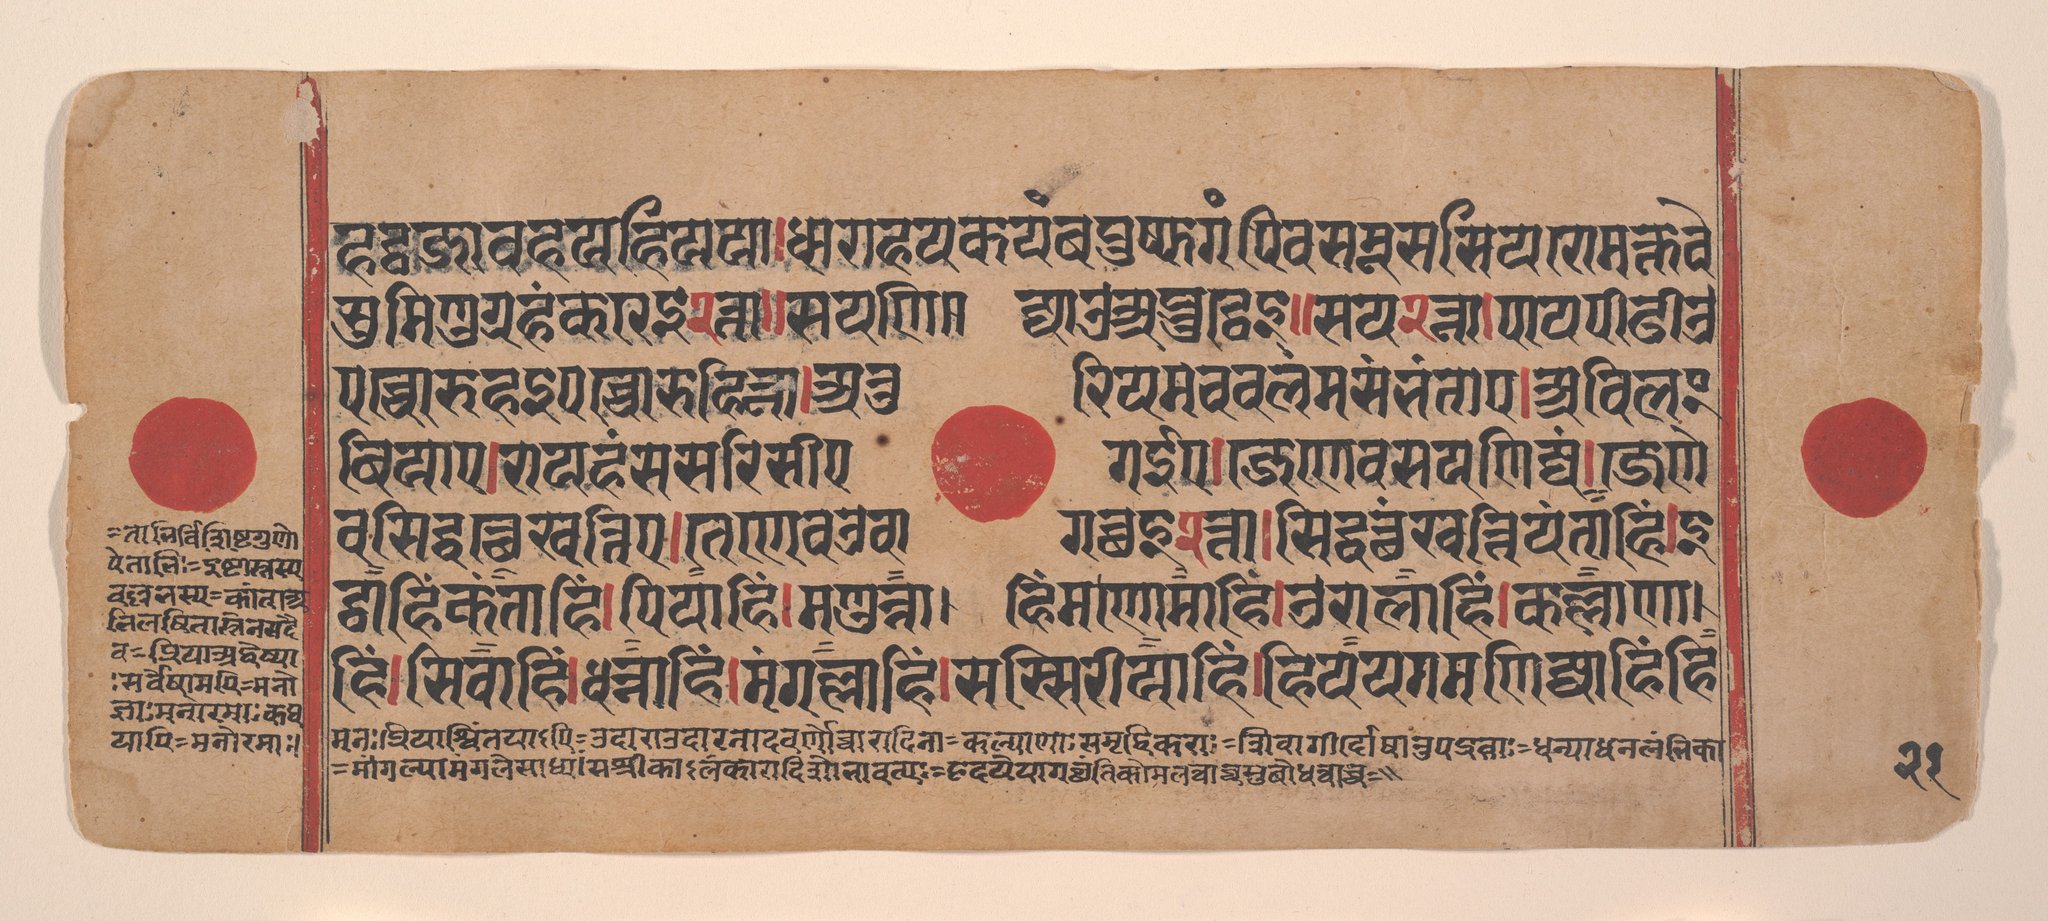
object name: folio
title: Page from a Dispersed Kalpa Sutra (Jain Book of Rituals)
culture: indian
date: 1401-1500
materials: gold, ink, paper, watercolor